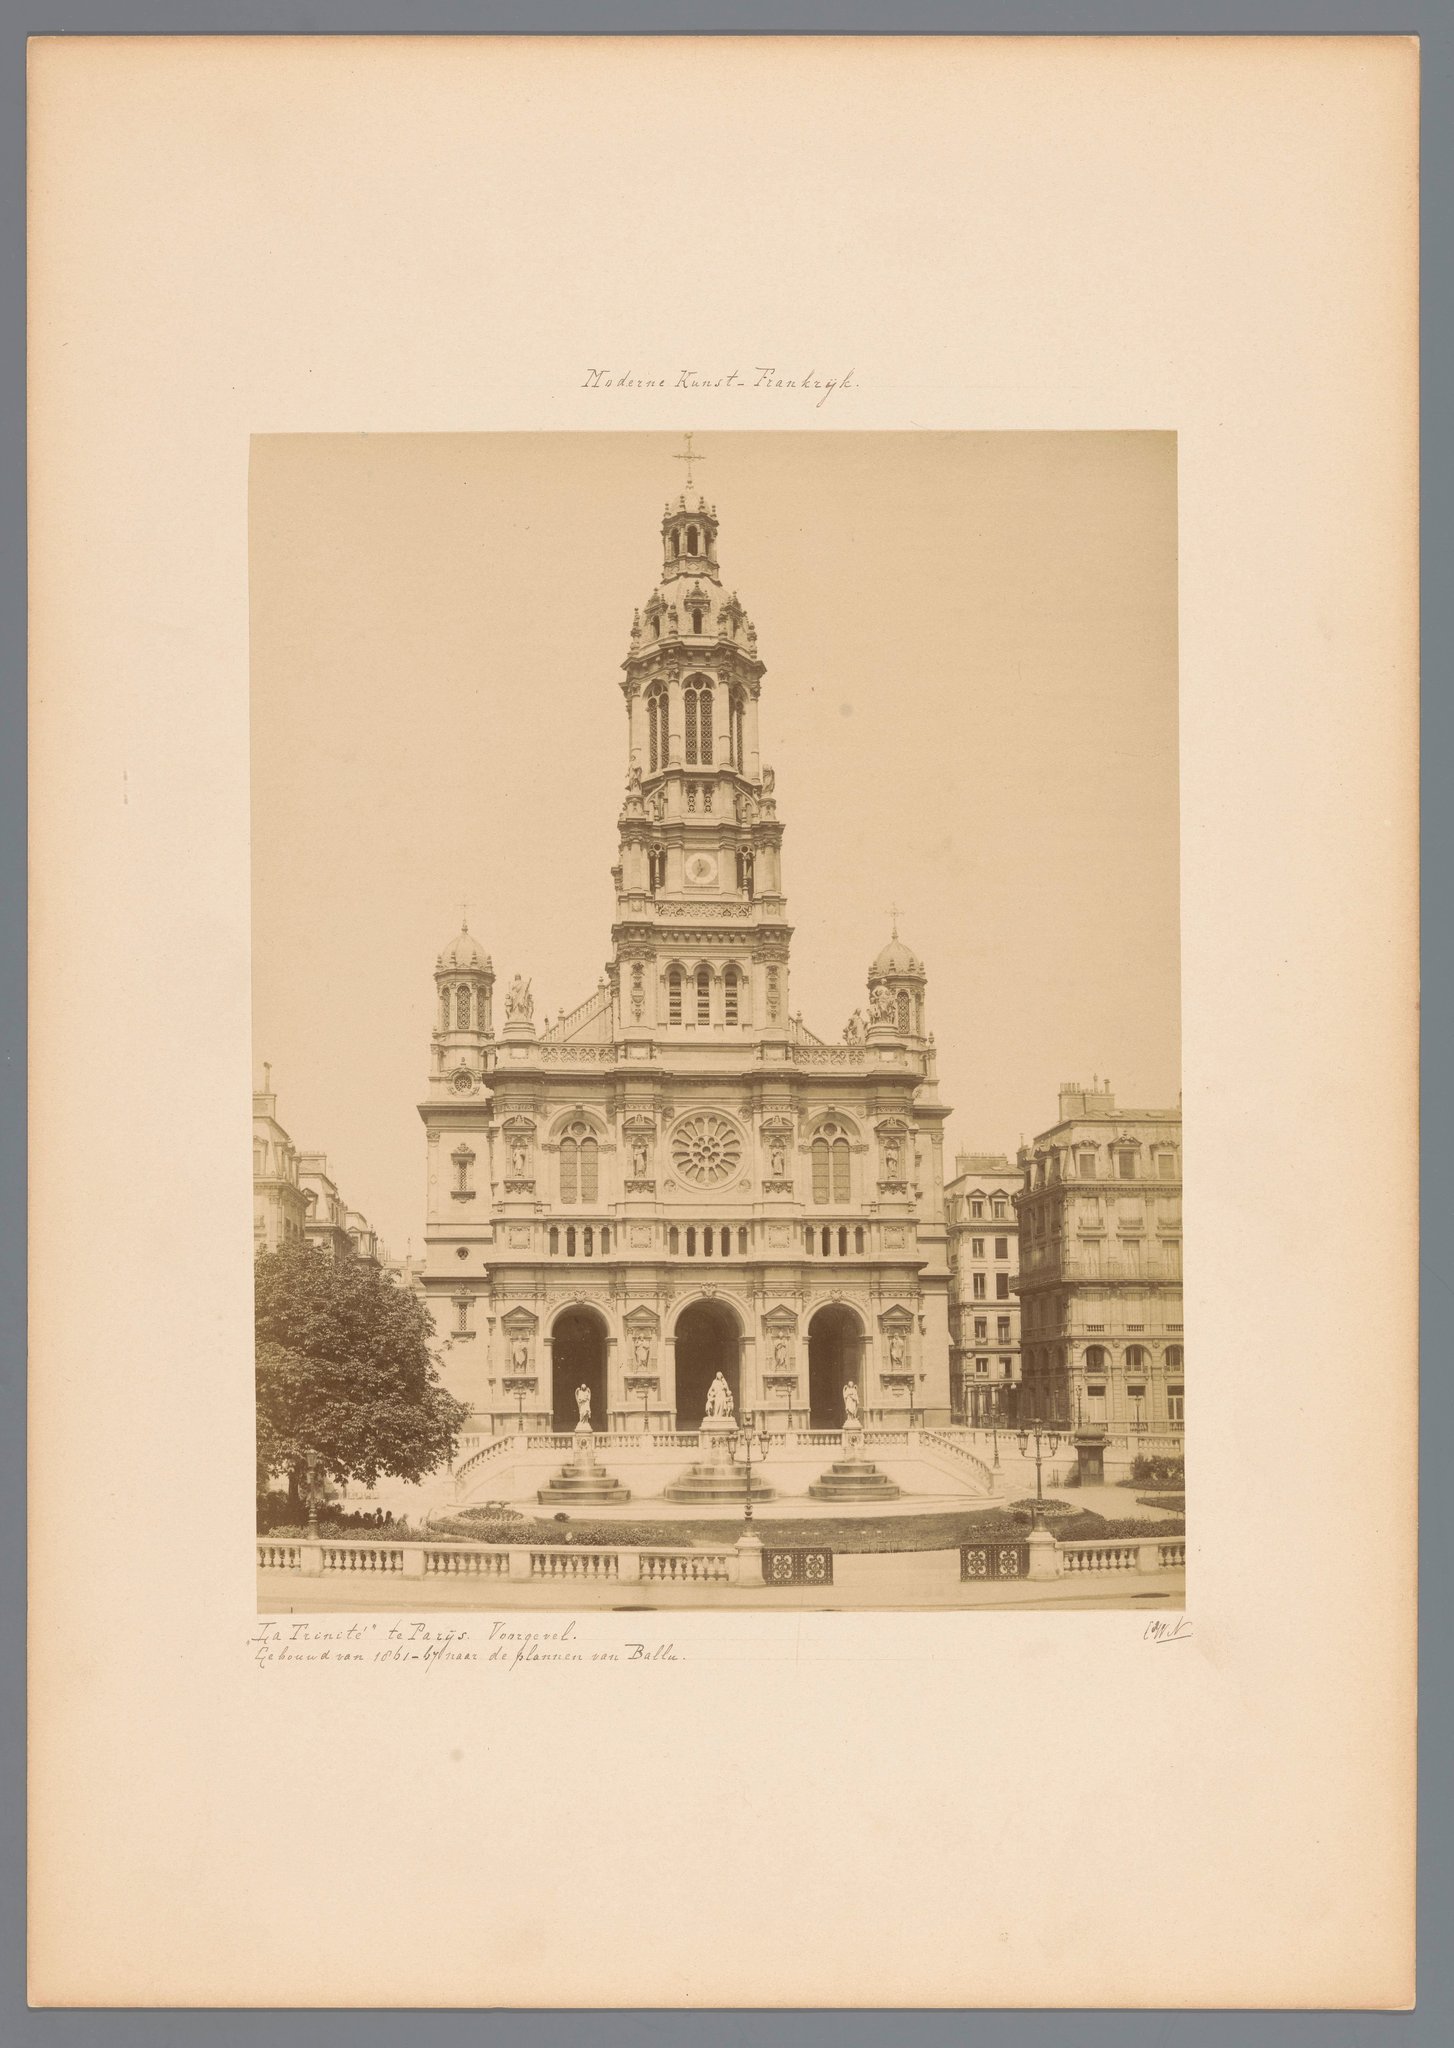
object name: photograph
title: Voorgevel van de Église de la Sainte-Trinité te Parijs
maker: Anonymous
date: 1875-1900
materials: cardboard, photographic support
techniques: albumen print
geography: paris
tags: tower, clock tower ~ monumental adornment, church (exterior), façade (of house or building)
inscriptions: inscription: ‘Moderne Kunst - Frankrijk. ,,La Trinité'' te Parijs (...) Gebouwd van 1861-67 naar de plannen van Ballu.’, collector's mark: ‘INSTITUUT VOOR KUNST- NIJVERHEIDSONDERWIJS GABRIËL METSUSTRAAT No. 16. AMSTERDAM’, inscription: ‘CWN.’, collector's mark: ‘KUNSTNIJVERHEIDSCHOOL QUELLINUS AMSTERDAM FRANS HALSSTRAAT 14.’